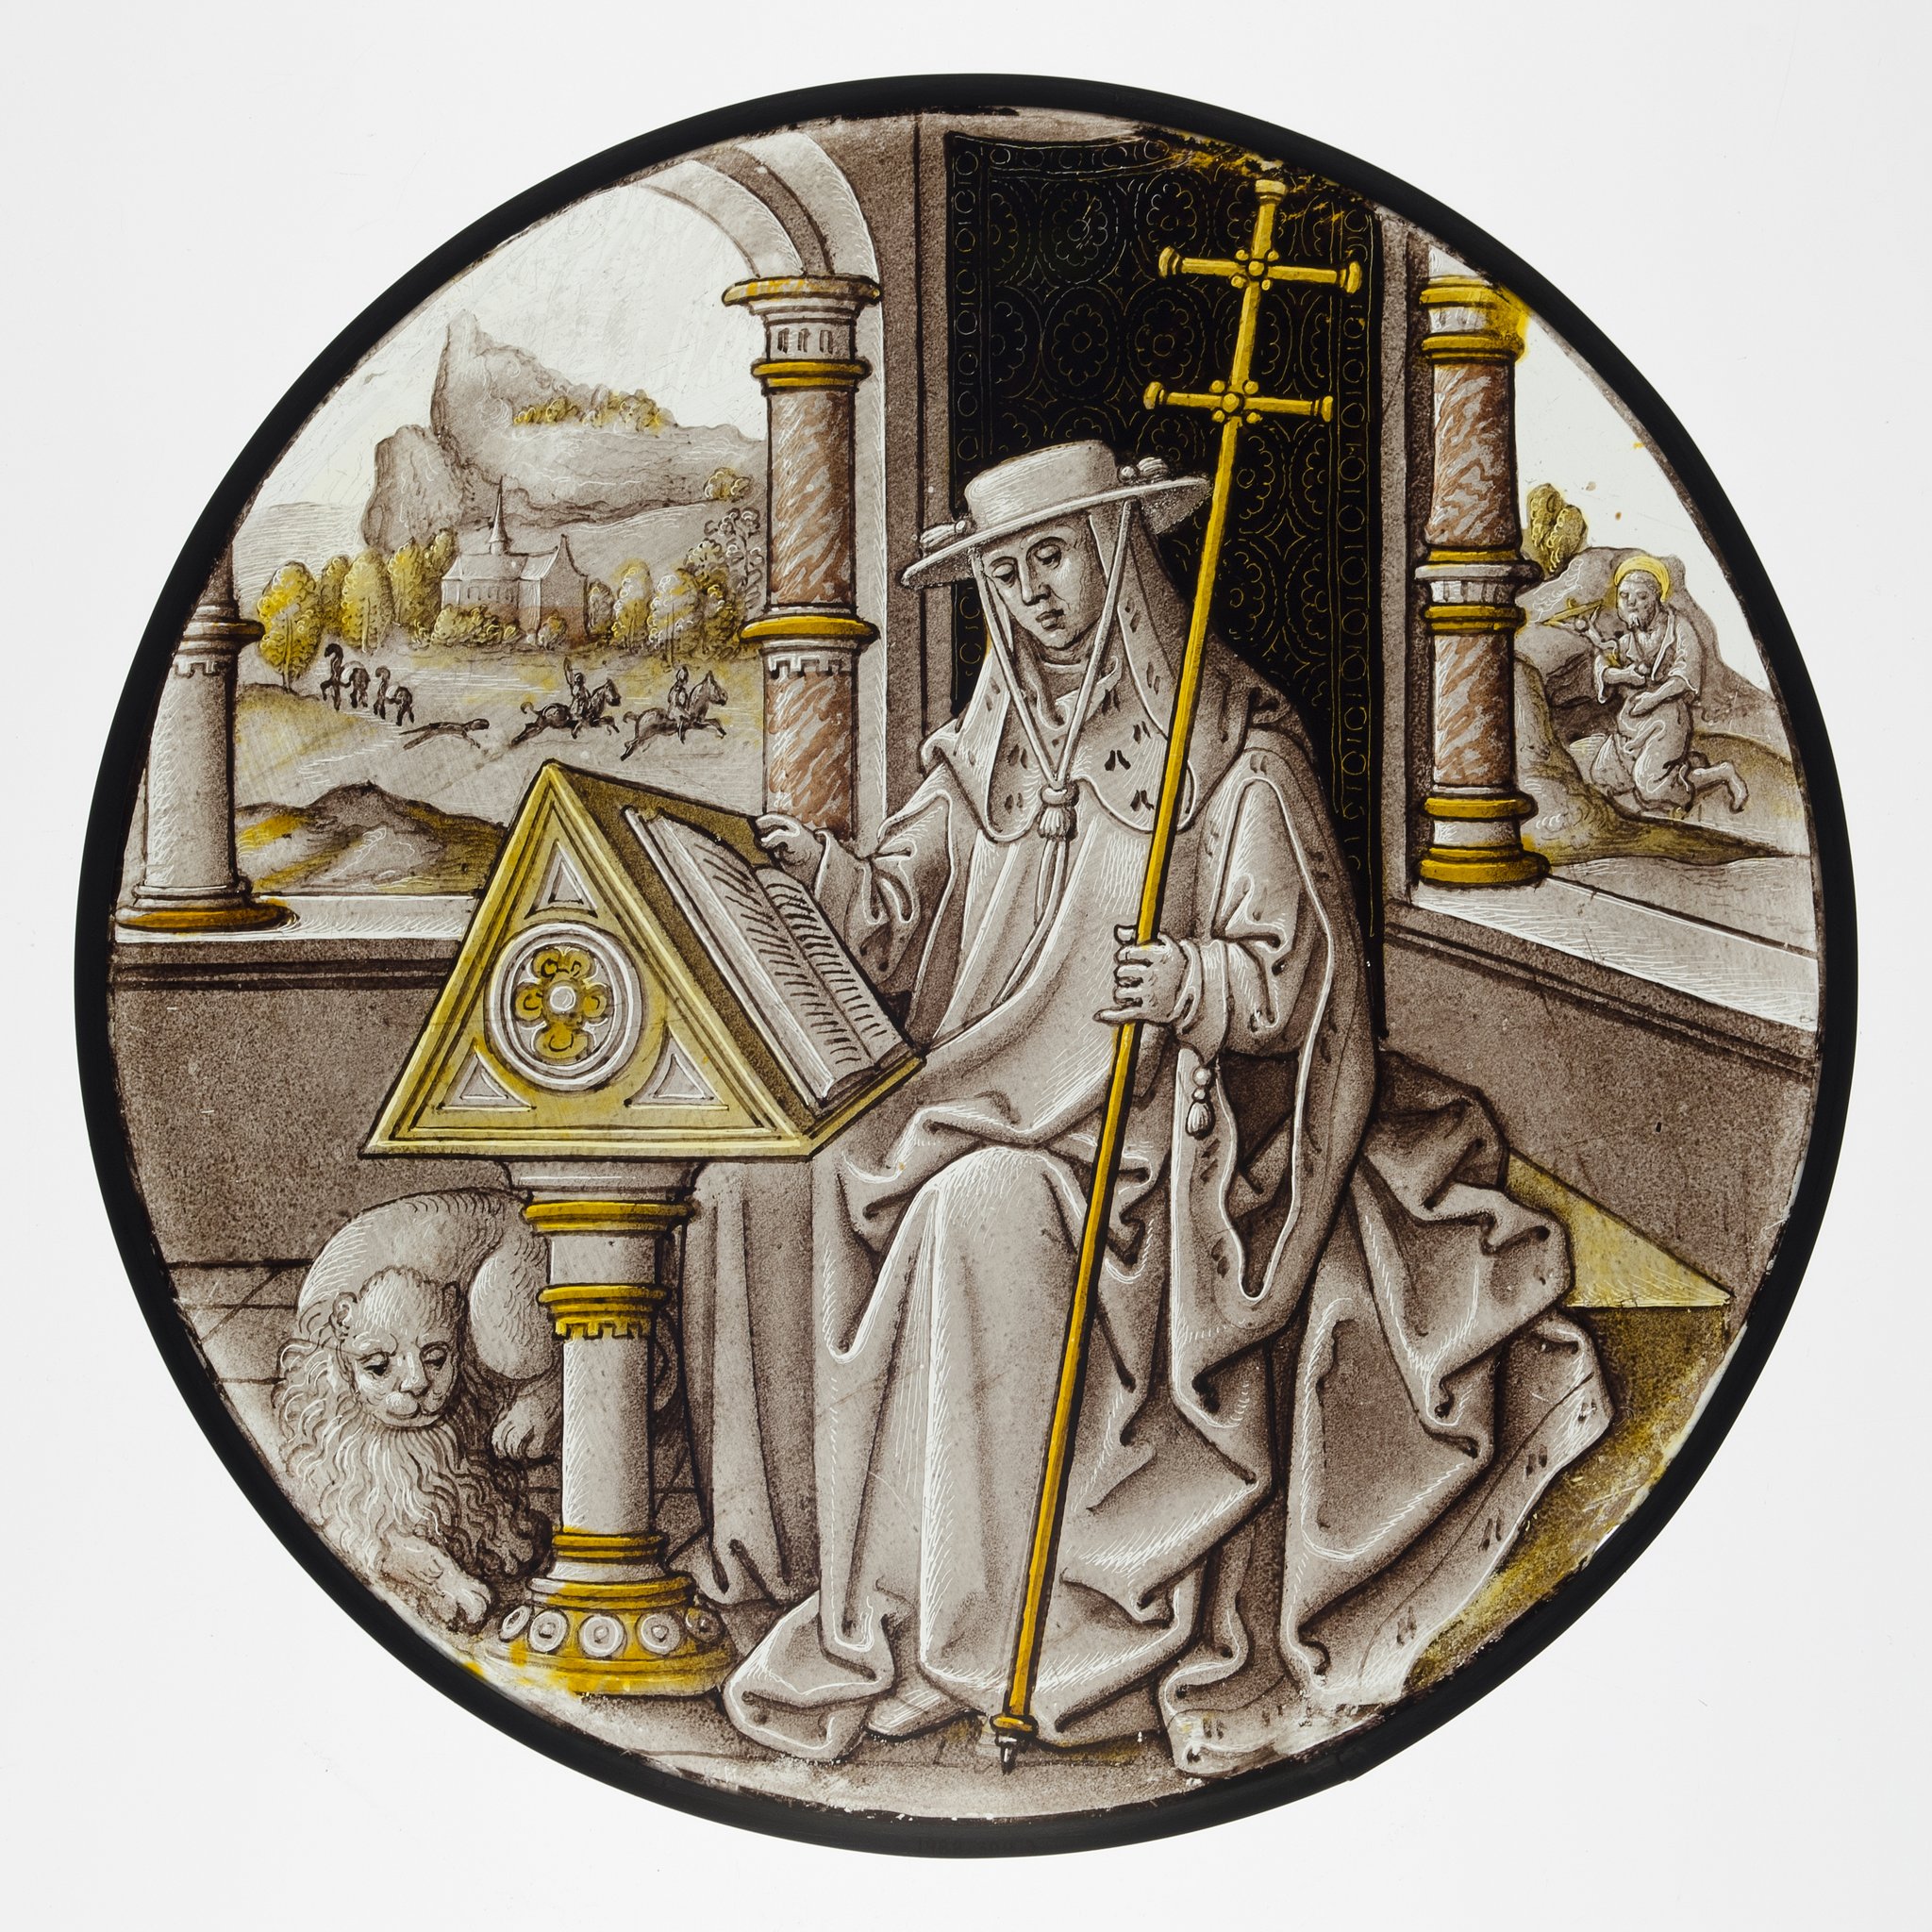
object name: roundel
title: Roundel with Saint Jerome in his Study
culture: south netherlandish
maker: pseudo-ortkens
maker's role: artist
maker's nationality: south netherlandish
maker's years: 1500-1530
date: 1520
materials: glass, paint, pigment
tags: men,reading,lions,saint jerome